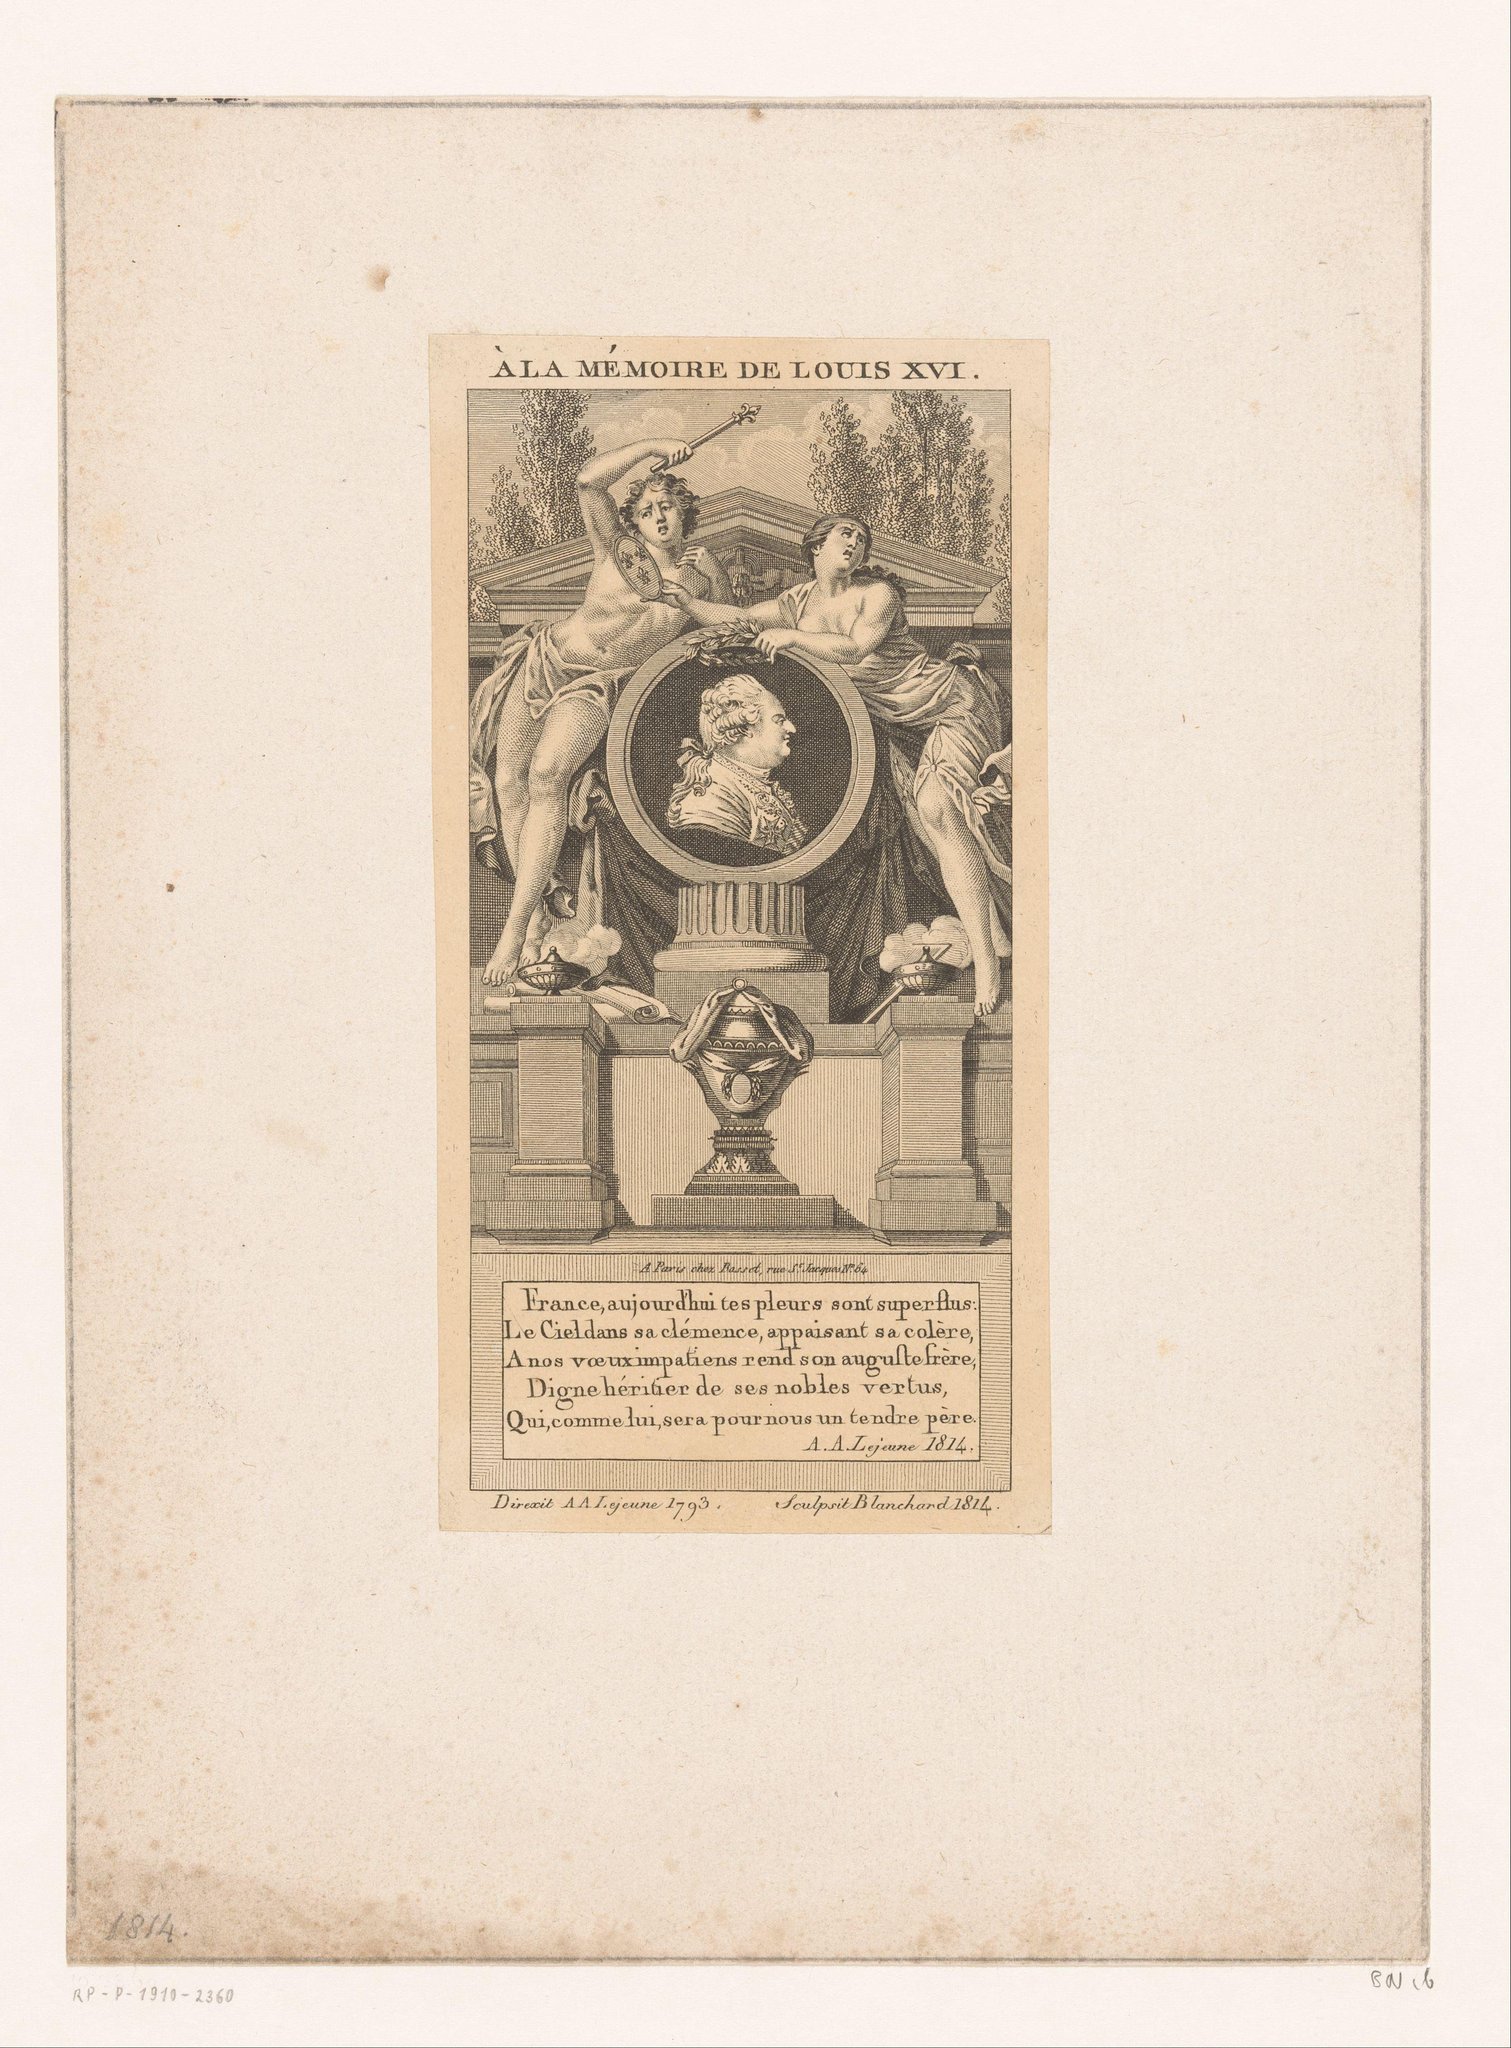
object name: print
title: À la mémoire de Louis XVI.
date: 1793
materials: paper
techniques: engraving, etching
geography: france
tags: paris, lodewijk xvi (koning van frankrijk), ornament ~ medallion, historical persons, death of human being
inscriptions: collector's mark: Lugt 2228